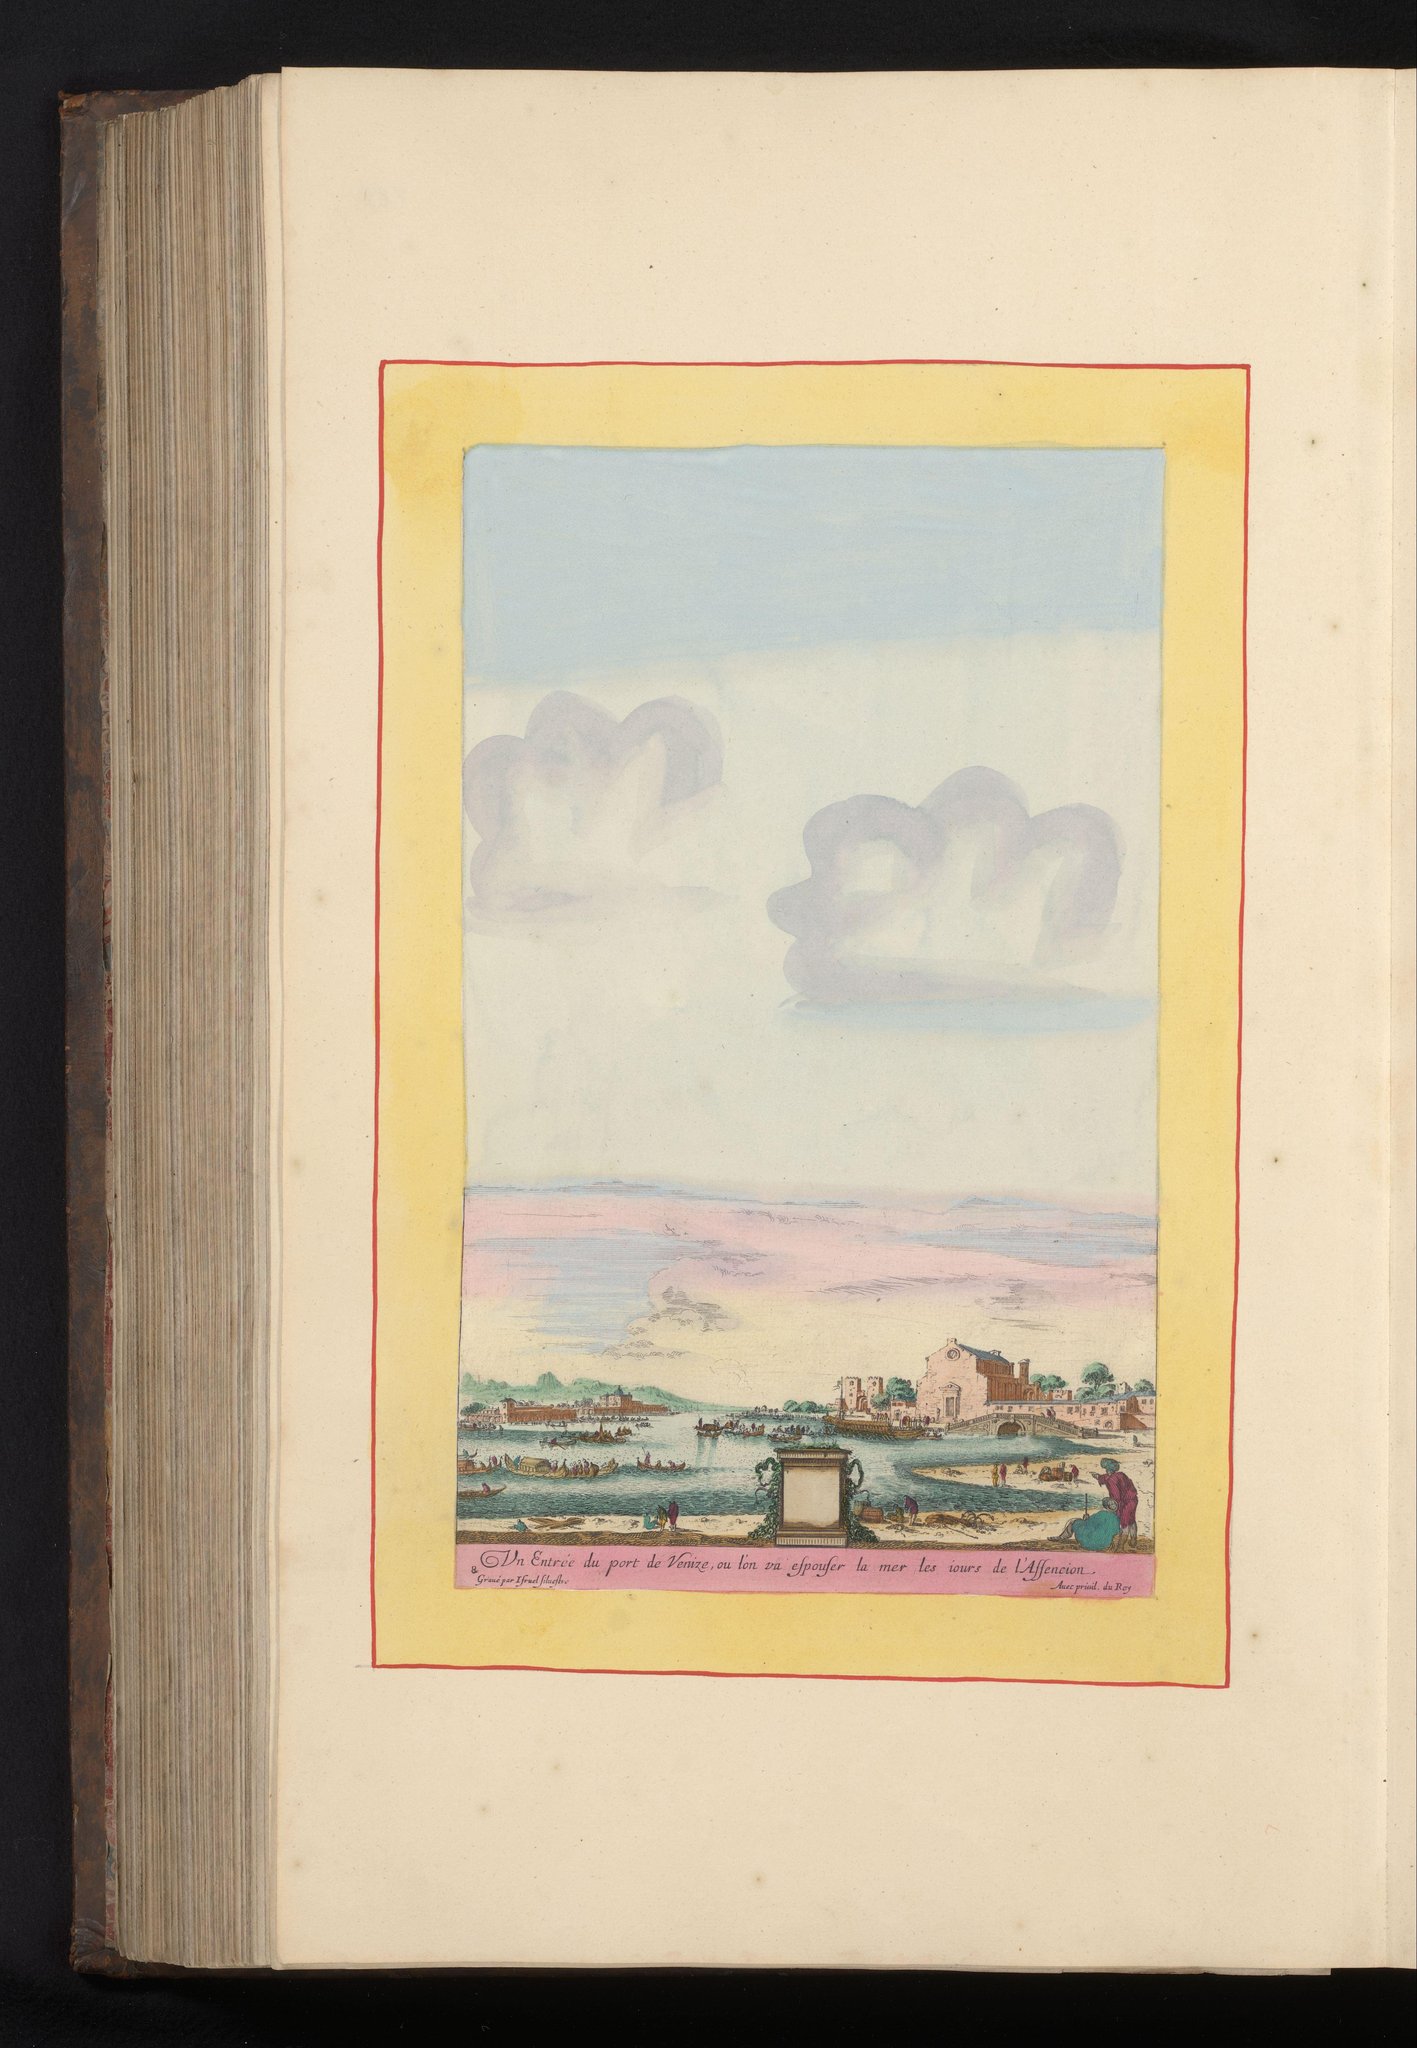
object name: album leaf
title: Plekken in Italië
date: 1631-1691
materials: paper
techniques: colour, etching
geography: france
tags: harbour, city-view, and landscape with man-made constructions, island, venice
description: Prent maakt deel uit van een reeks van 12 prenten met gezichten op plekken in Italië. De prent is langs de bovenrand van de voorstelling afgescheurd. De voorstelling is aan de bovenzijde aangevuld met een geschilderde lucht.